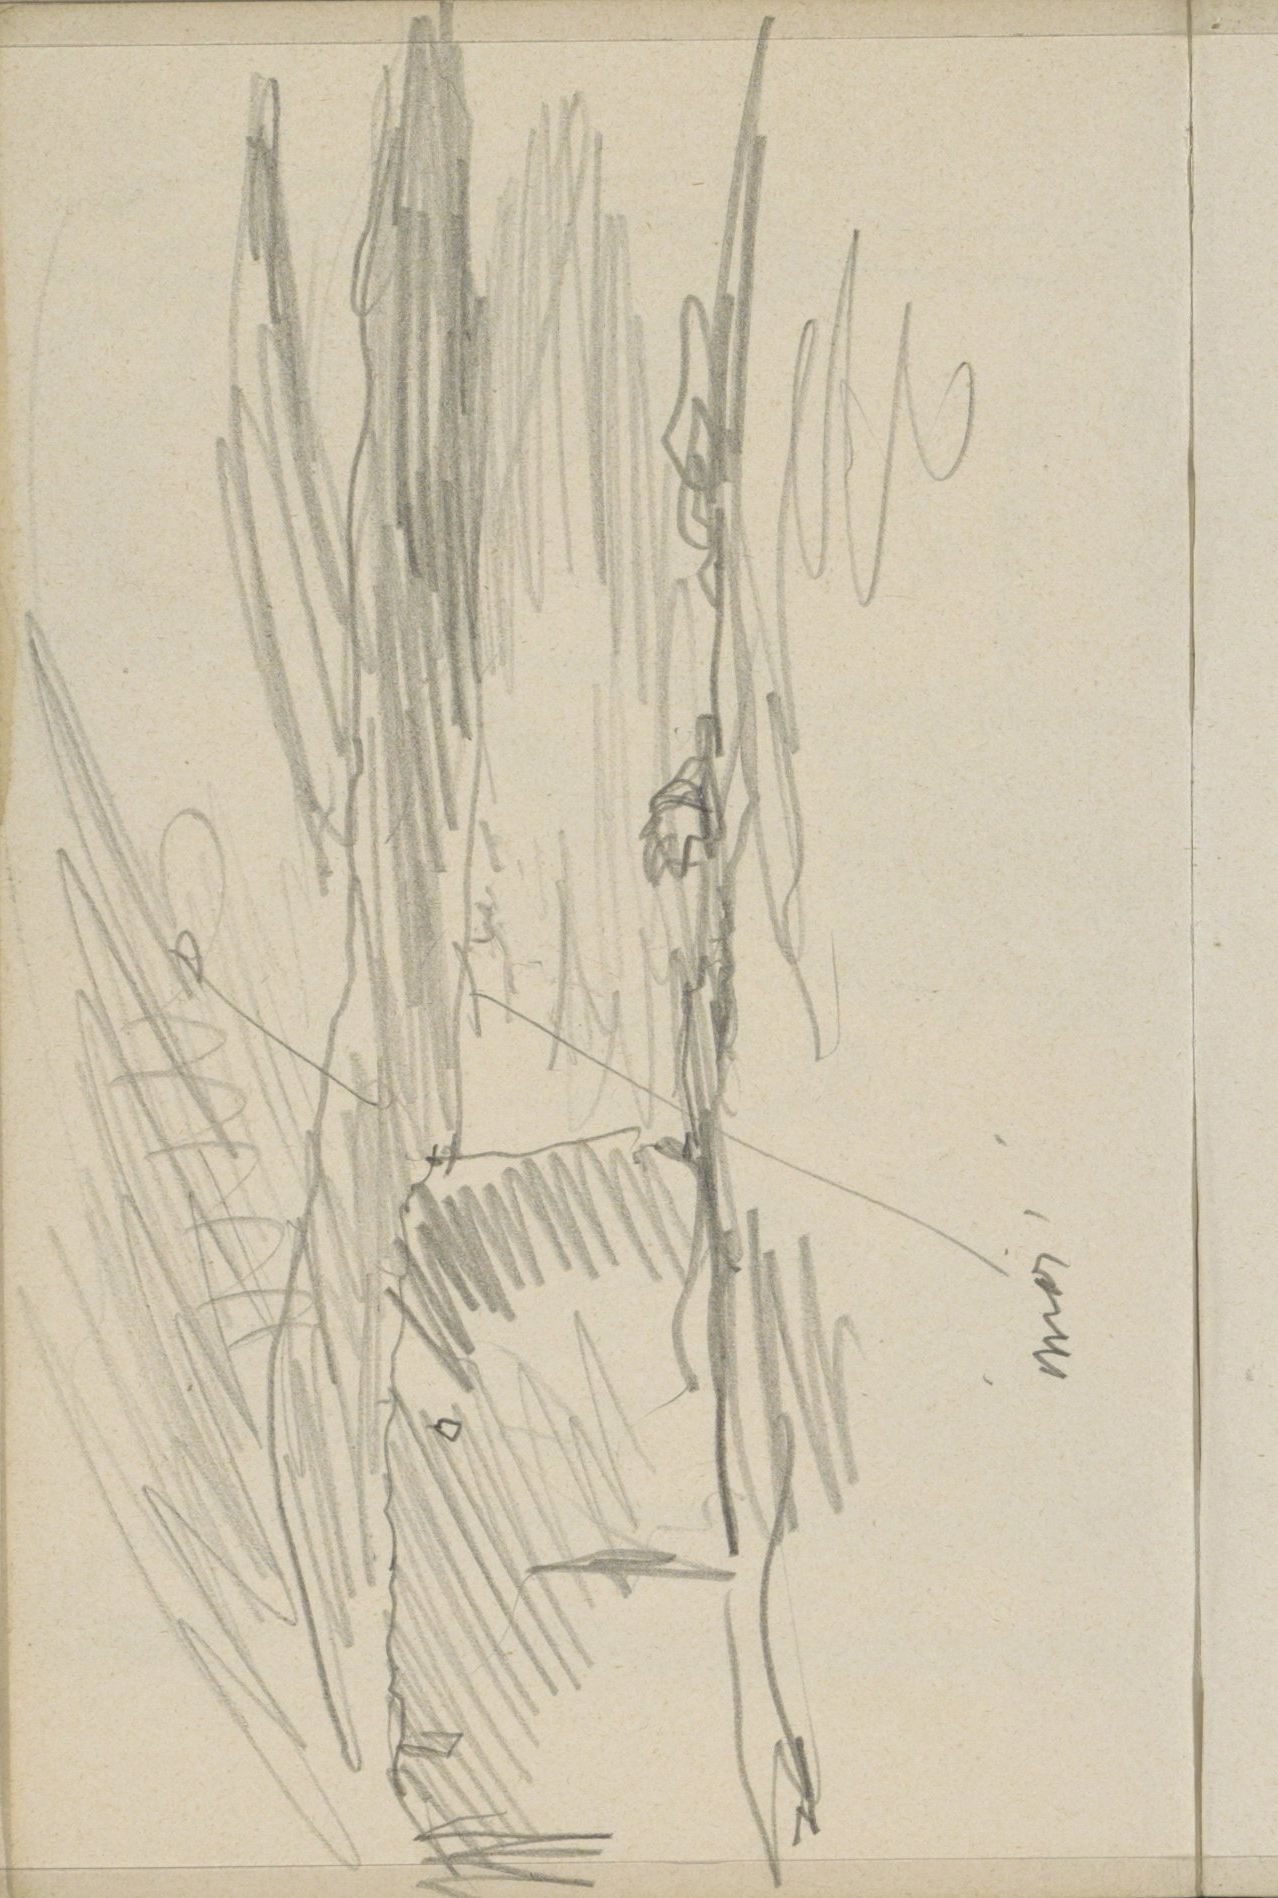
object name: sketchbook leaf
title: Landschap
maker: george hendrik breitner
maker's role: draughtsman, painter, print maker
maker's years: 1857-1923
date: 1914-1923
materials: paper, pencil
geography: north holland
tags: landscapes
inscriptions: kleurnotitie, handgeschreven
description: Landschap. Pagina 71 uit een schetsboek met 43 bladen vervaardigd te Amsterdam.